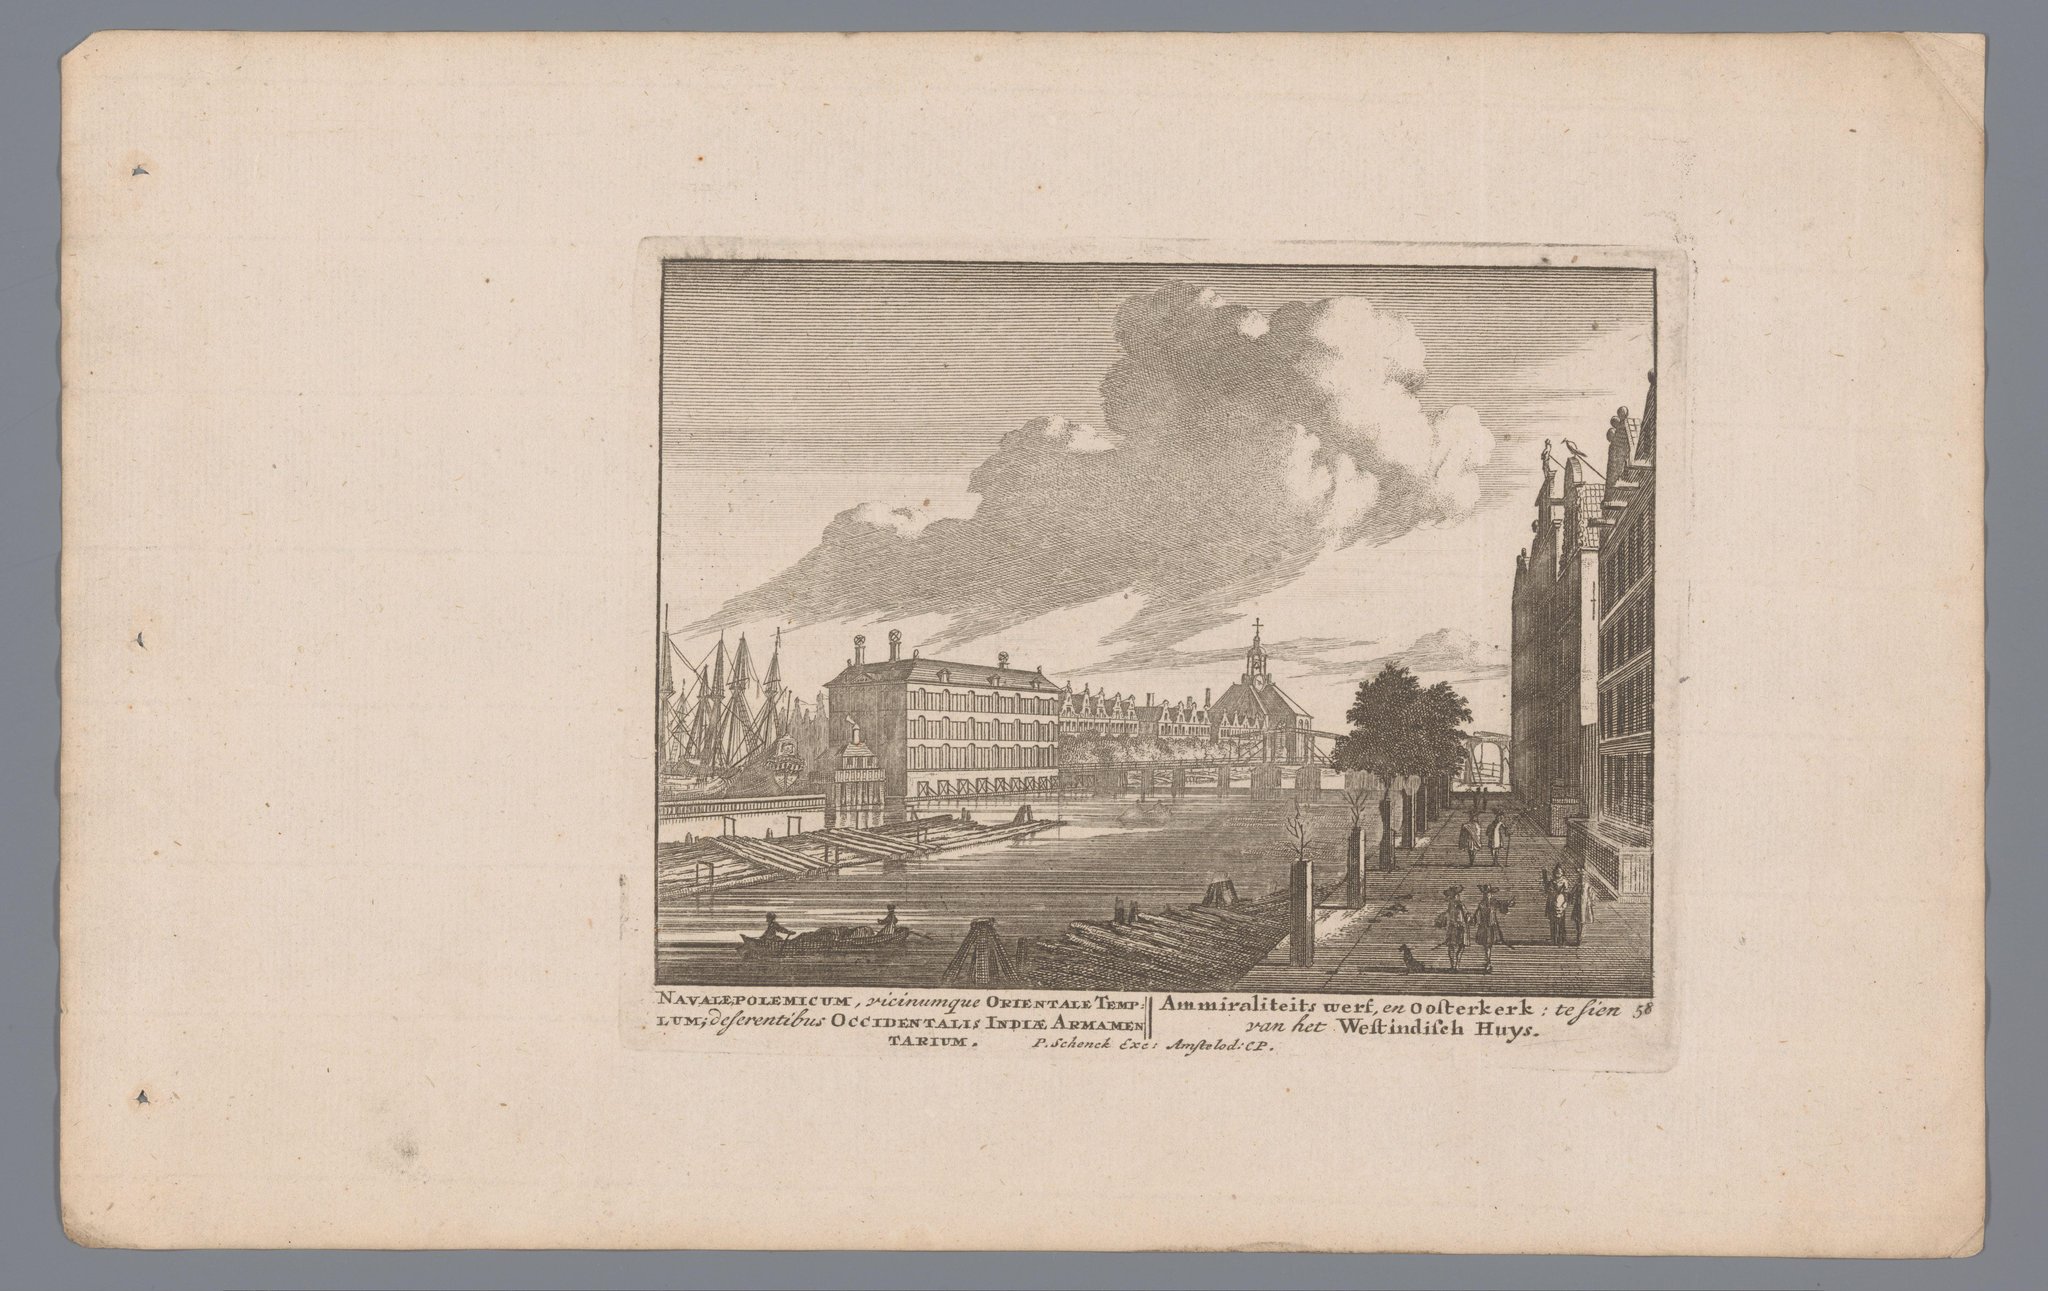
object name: print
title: Gezicht op 's Lands Zeemagazijn (Admiraliteitsmagazijn), de Admiraliteitswerf en de Oosterkerk te Amsterdam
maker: pieter schenk (i)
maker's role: print maker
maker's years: 1660-1711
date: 1670-1711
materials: paper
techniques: etching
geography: amsterdam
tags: pier, quay, wharf, civic architecture; edifices; dwellings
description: Gezicht op het 's Lands Zeemagazijn, de Admiraliteitswerf en de Oosterkerk vanaf het Westindisch huis.